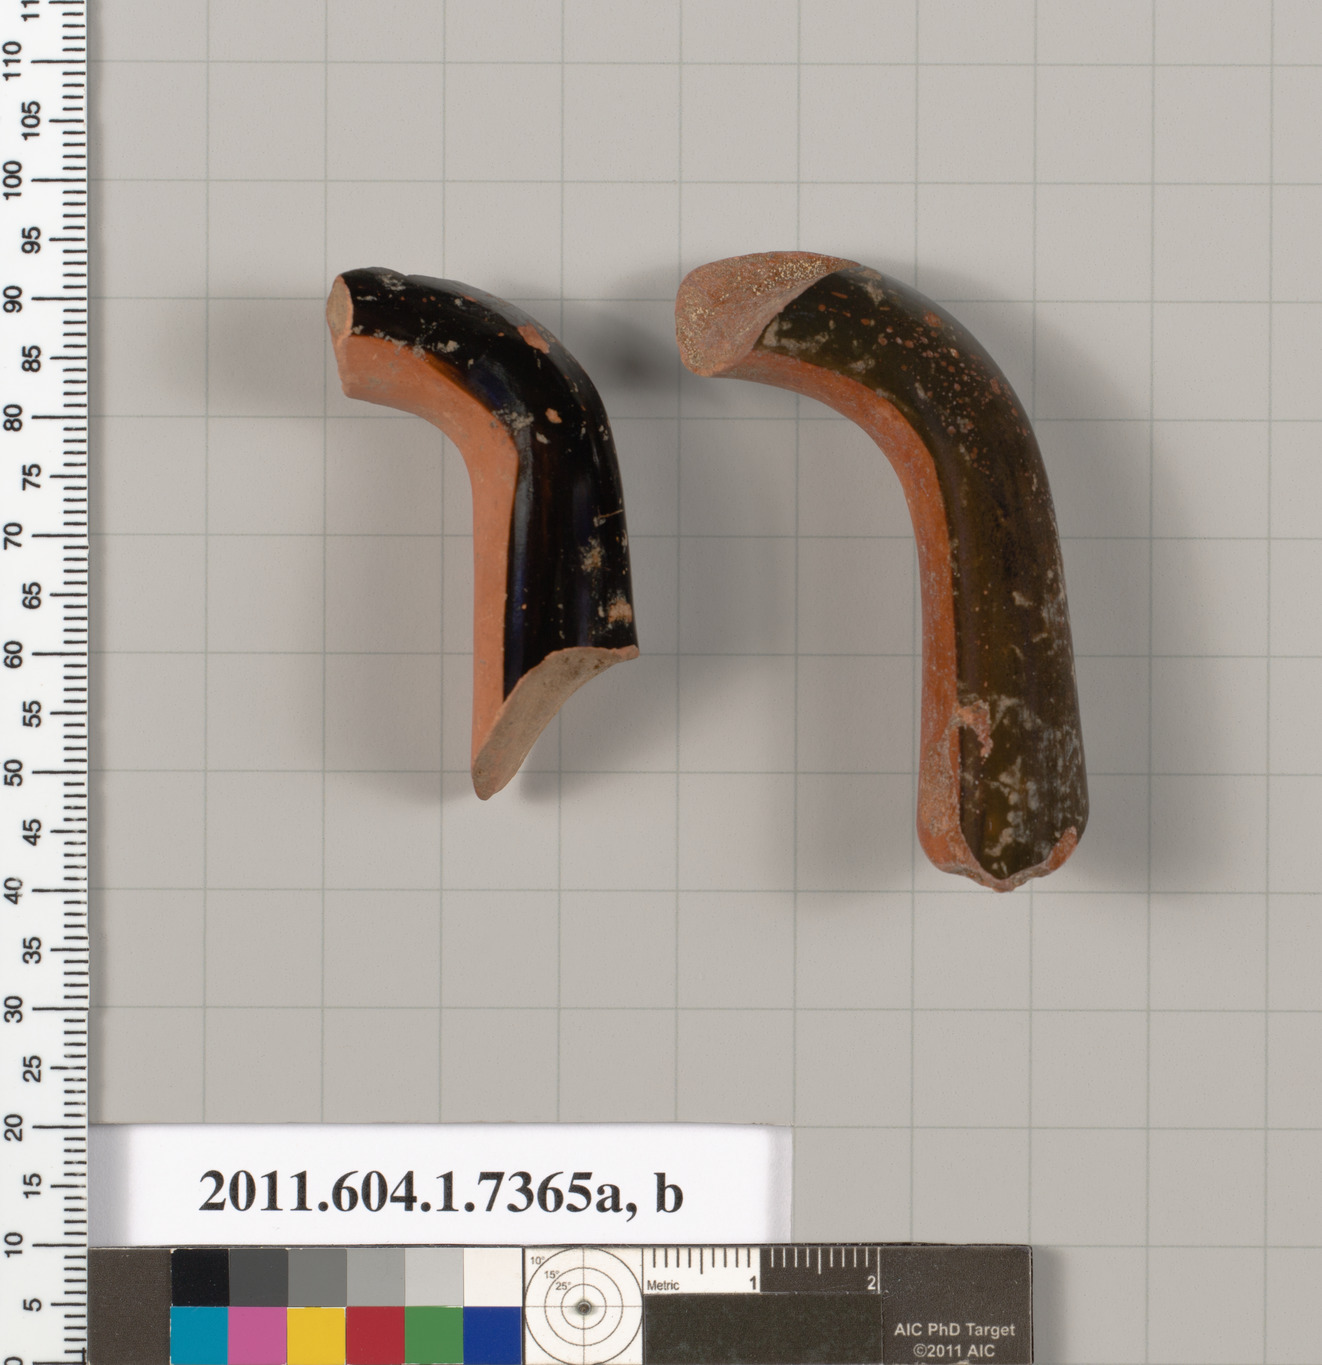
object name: kylix fragment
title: Terracotta fragments of kylikes (drinking cups)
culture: greek, attic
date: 500-480 BCE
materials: terracotta